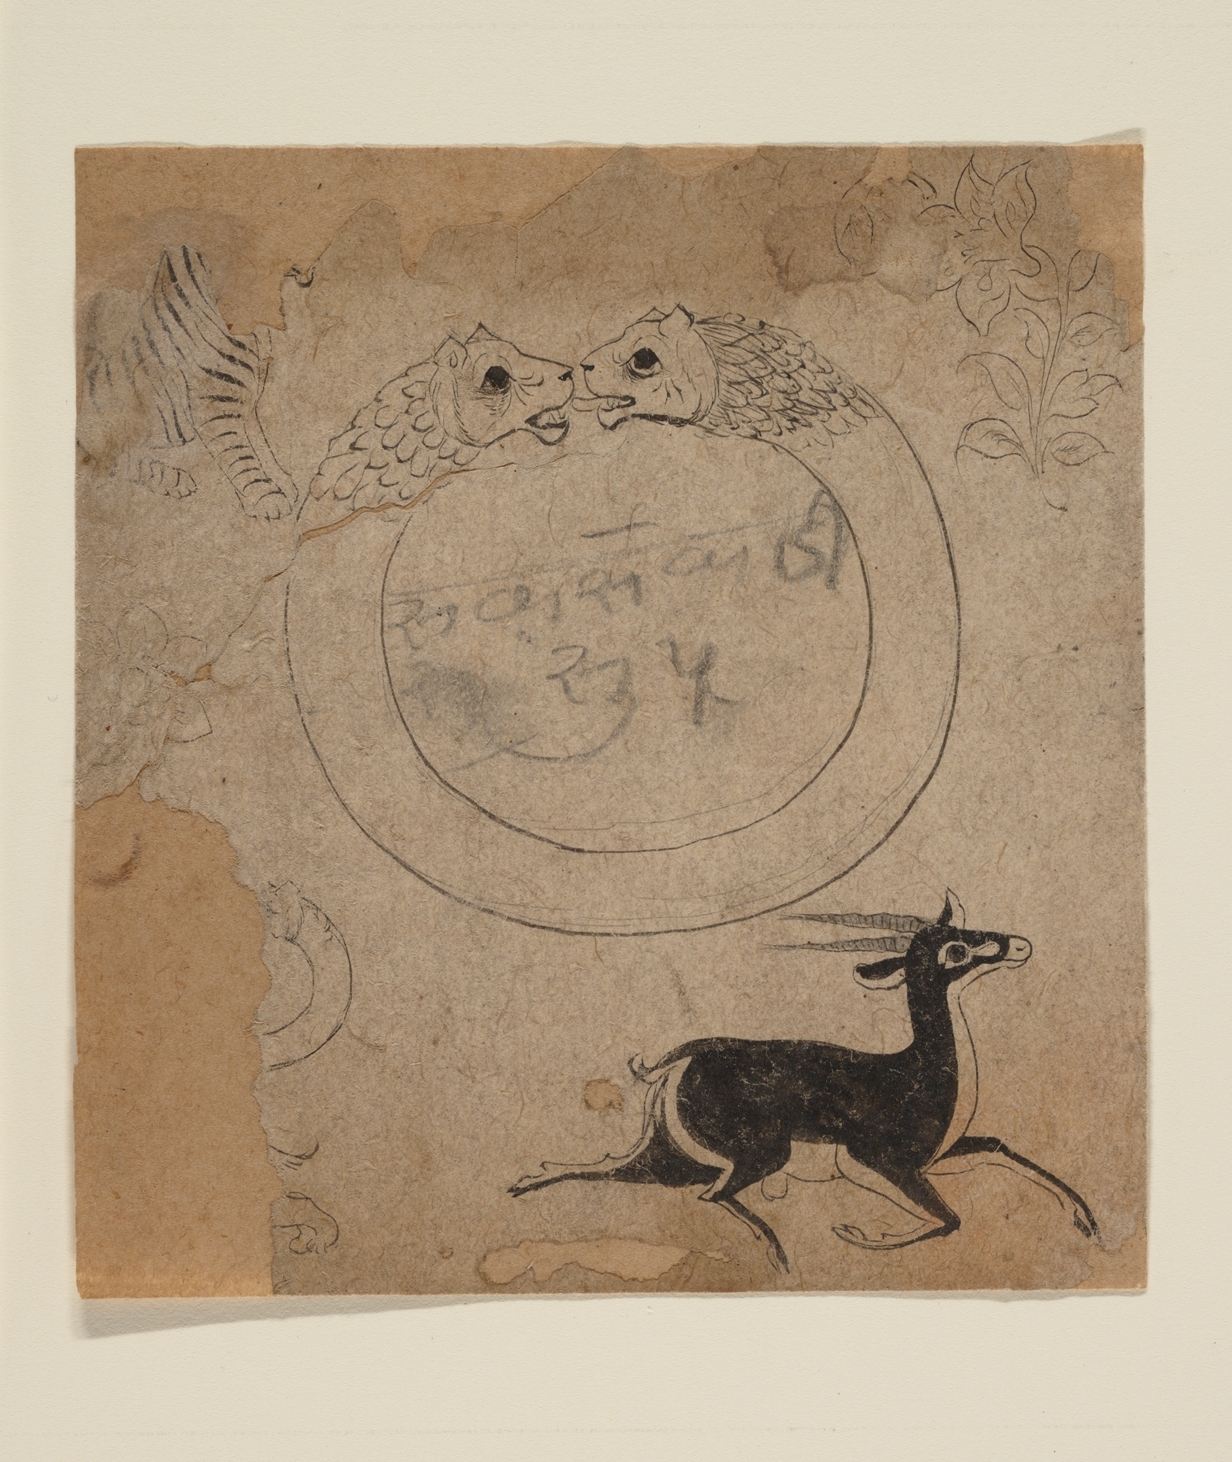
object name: painting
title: Design for a Bangle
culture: india, pahari hills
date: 1801-1833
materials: ink, paper, watercolor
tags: animals